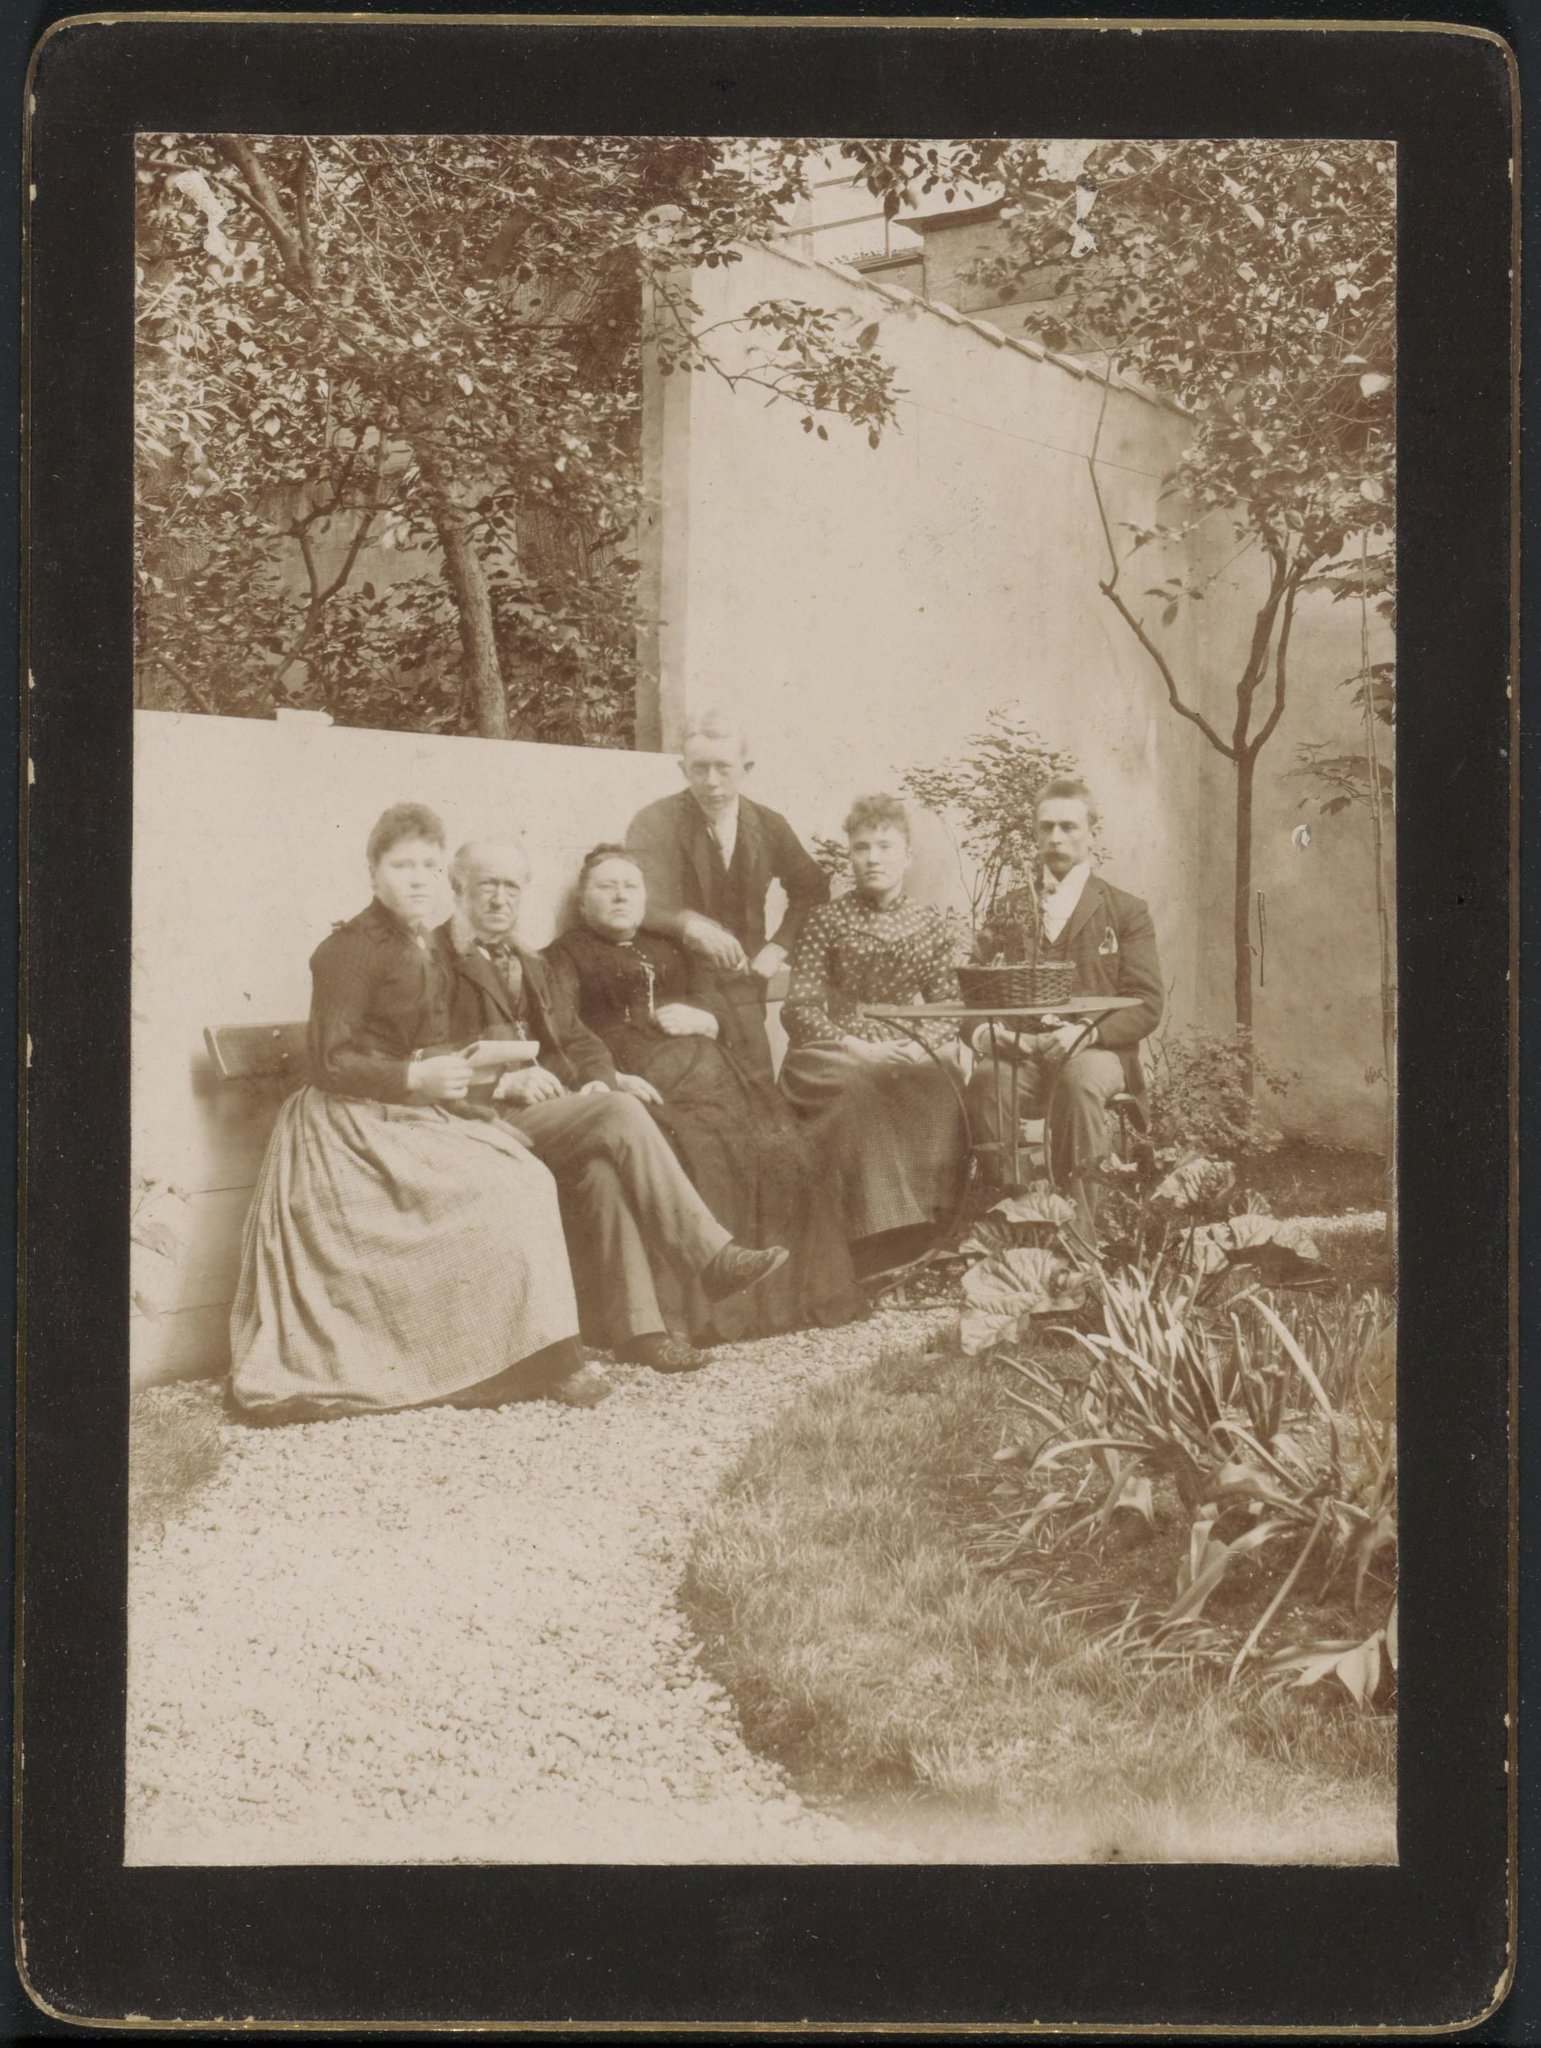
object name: photograph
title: Portret van een familie in een tuin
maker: Anonymous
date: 1900-1920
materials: cardboard, paper, photographic support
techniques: daylight paper print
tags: three generations (family group)